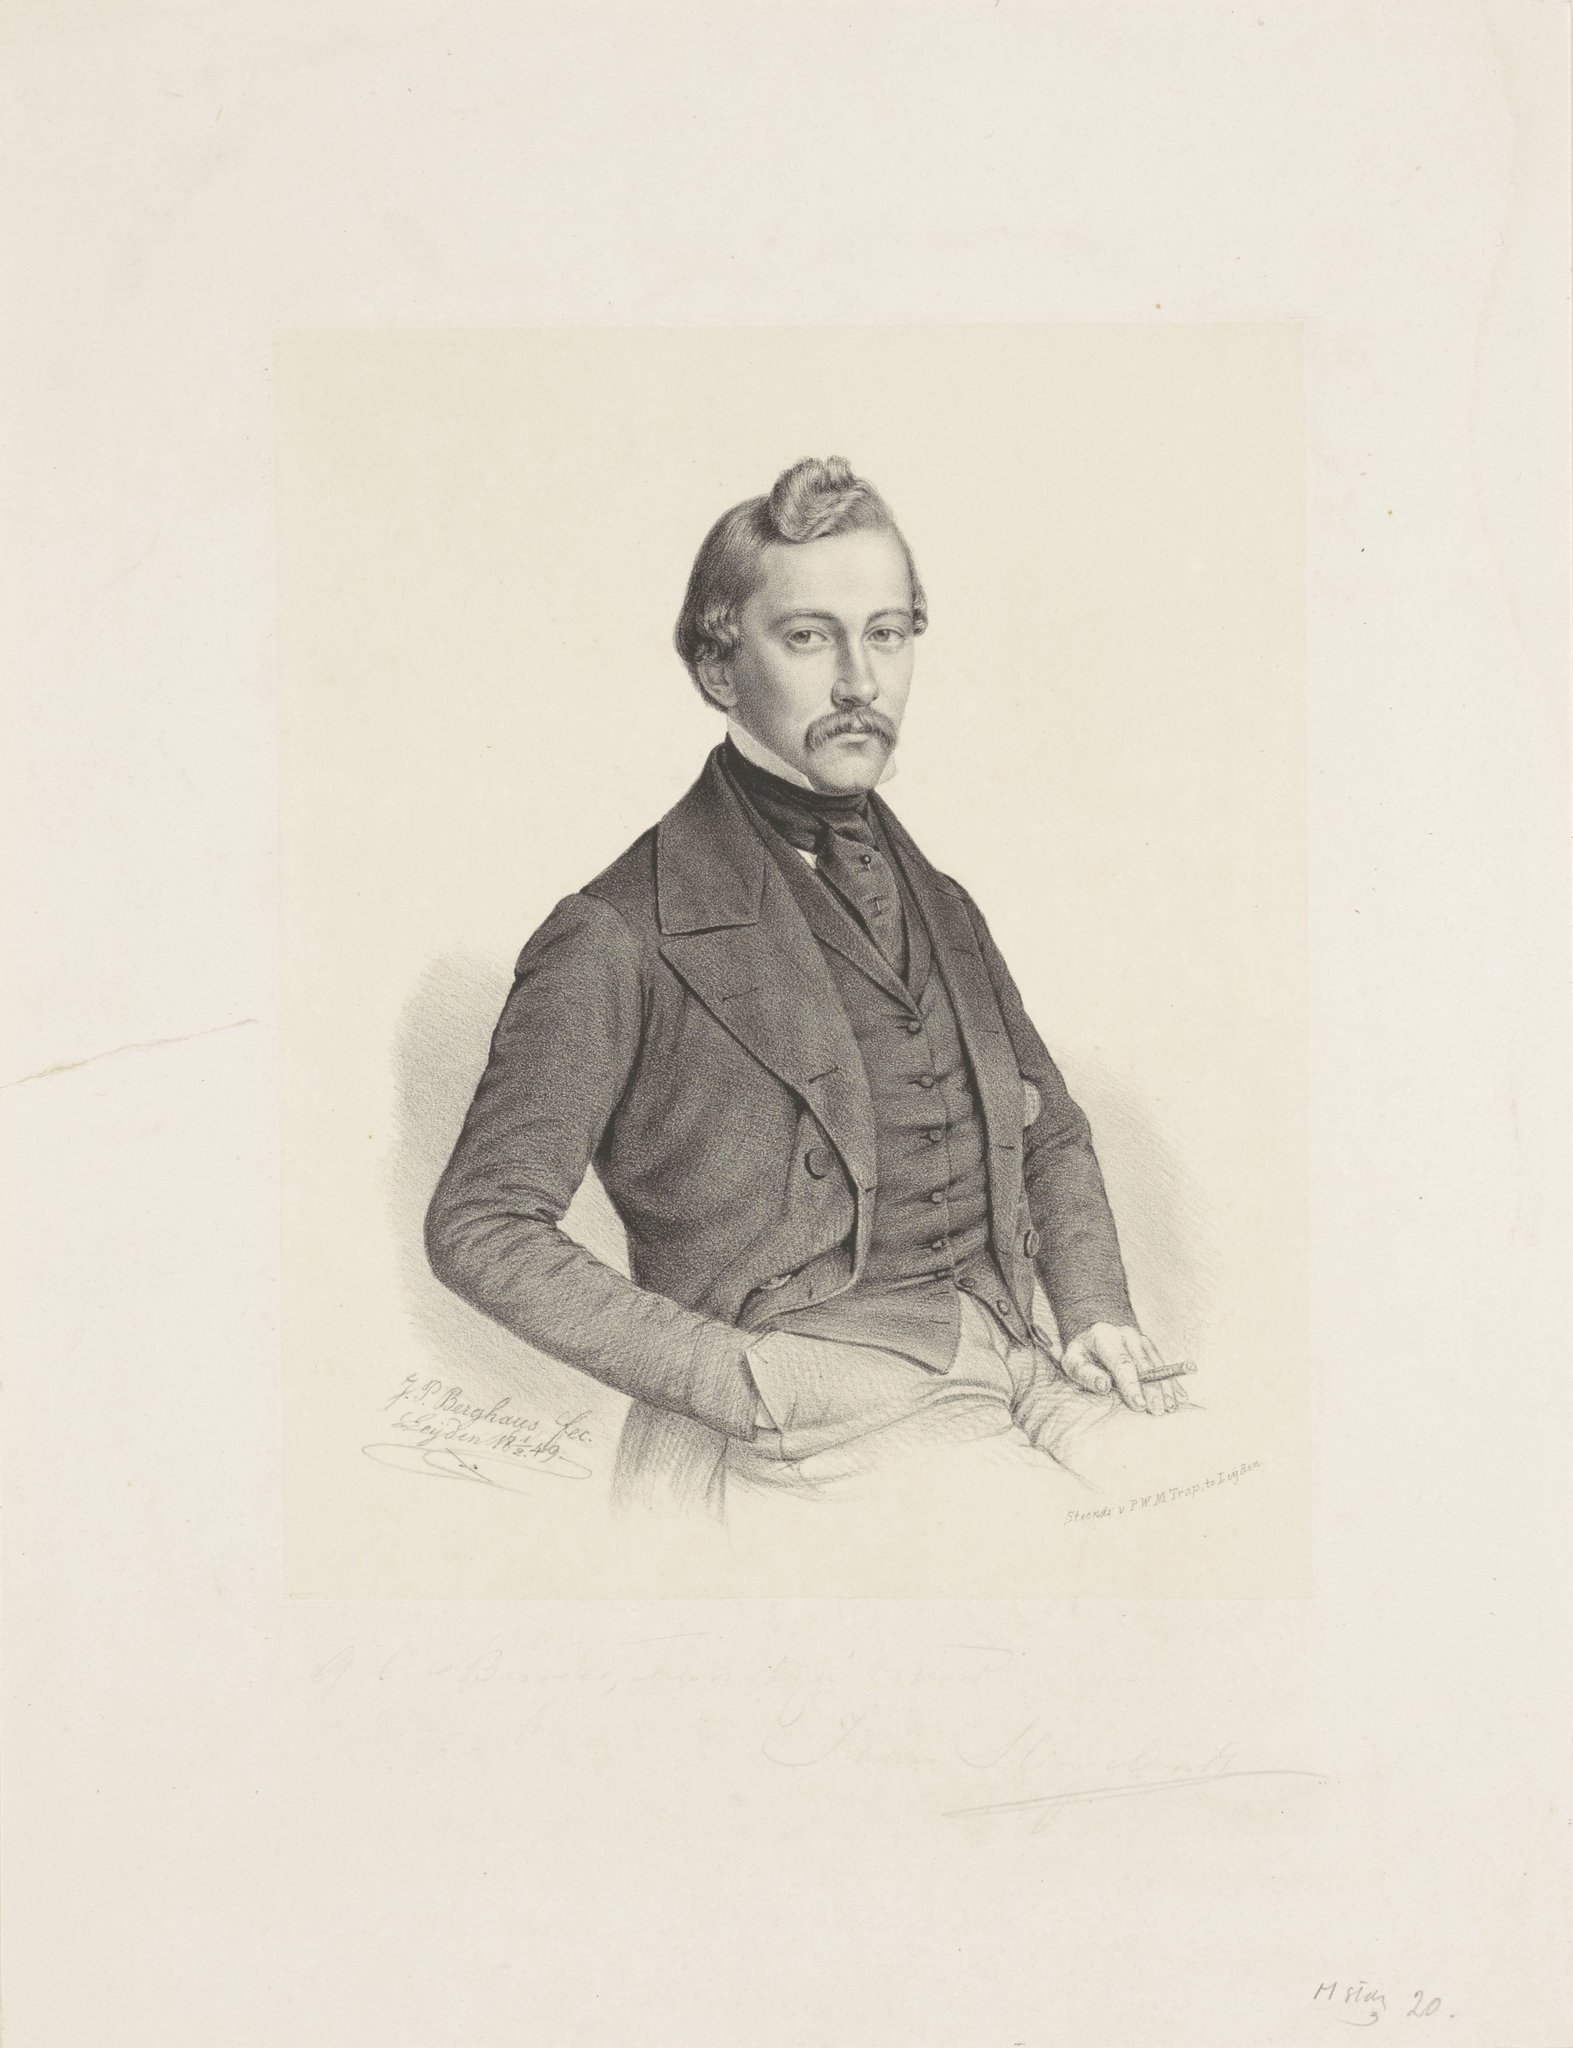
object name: print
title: Portret van een onbekende man, mogelijk J. van Slingelandt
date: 1849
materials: paper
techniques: lithograph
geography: leiden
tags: cigar, historical persons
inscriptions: collector's mark: Lugt 2228, inscription: ‘G. C. B(...) / J. van Slingelandt’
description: De geportretteerde zit en heeft zijn rechterhand in zijn broekzak gestoken. In zijn linkerhand heeft hij een sigaar.